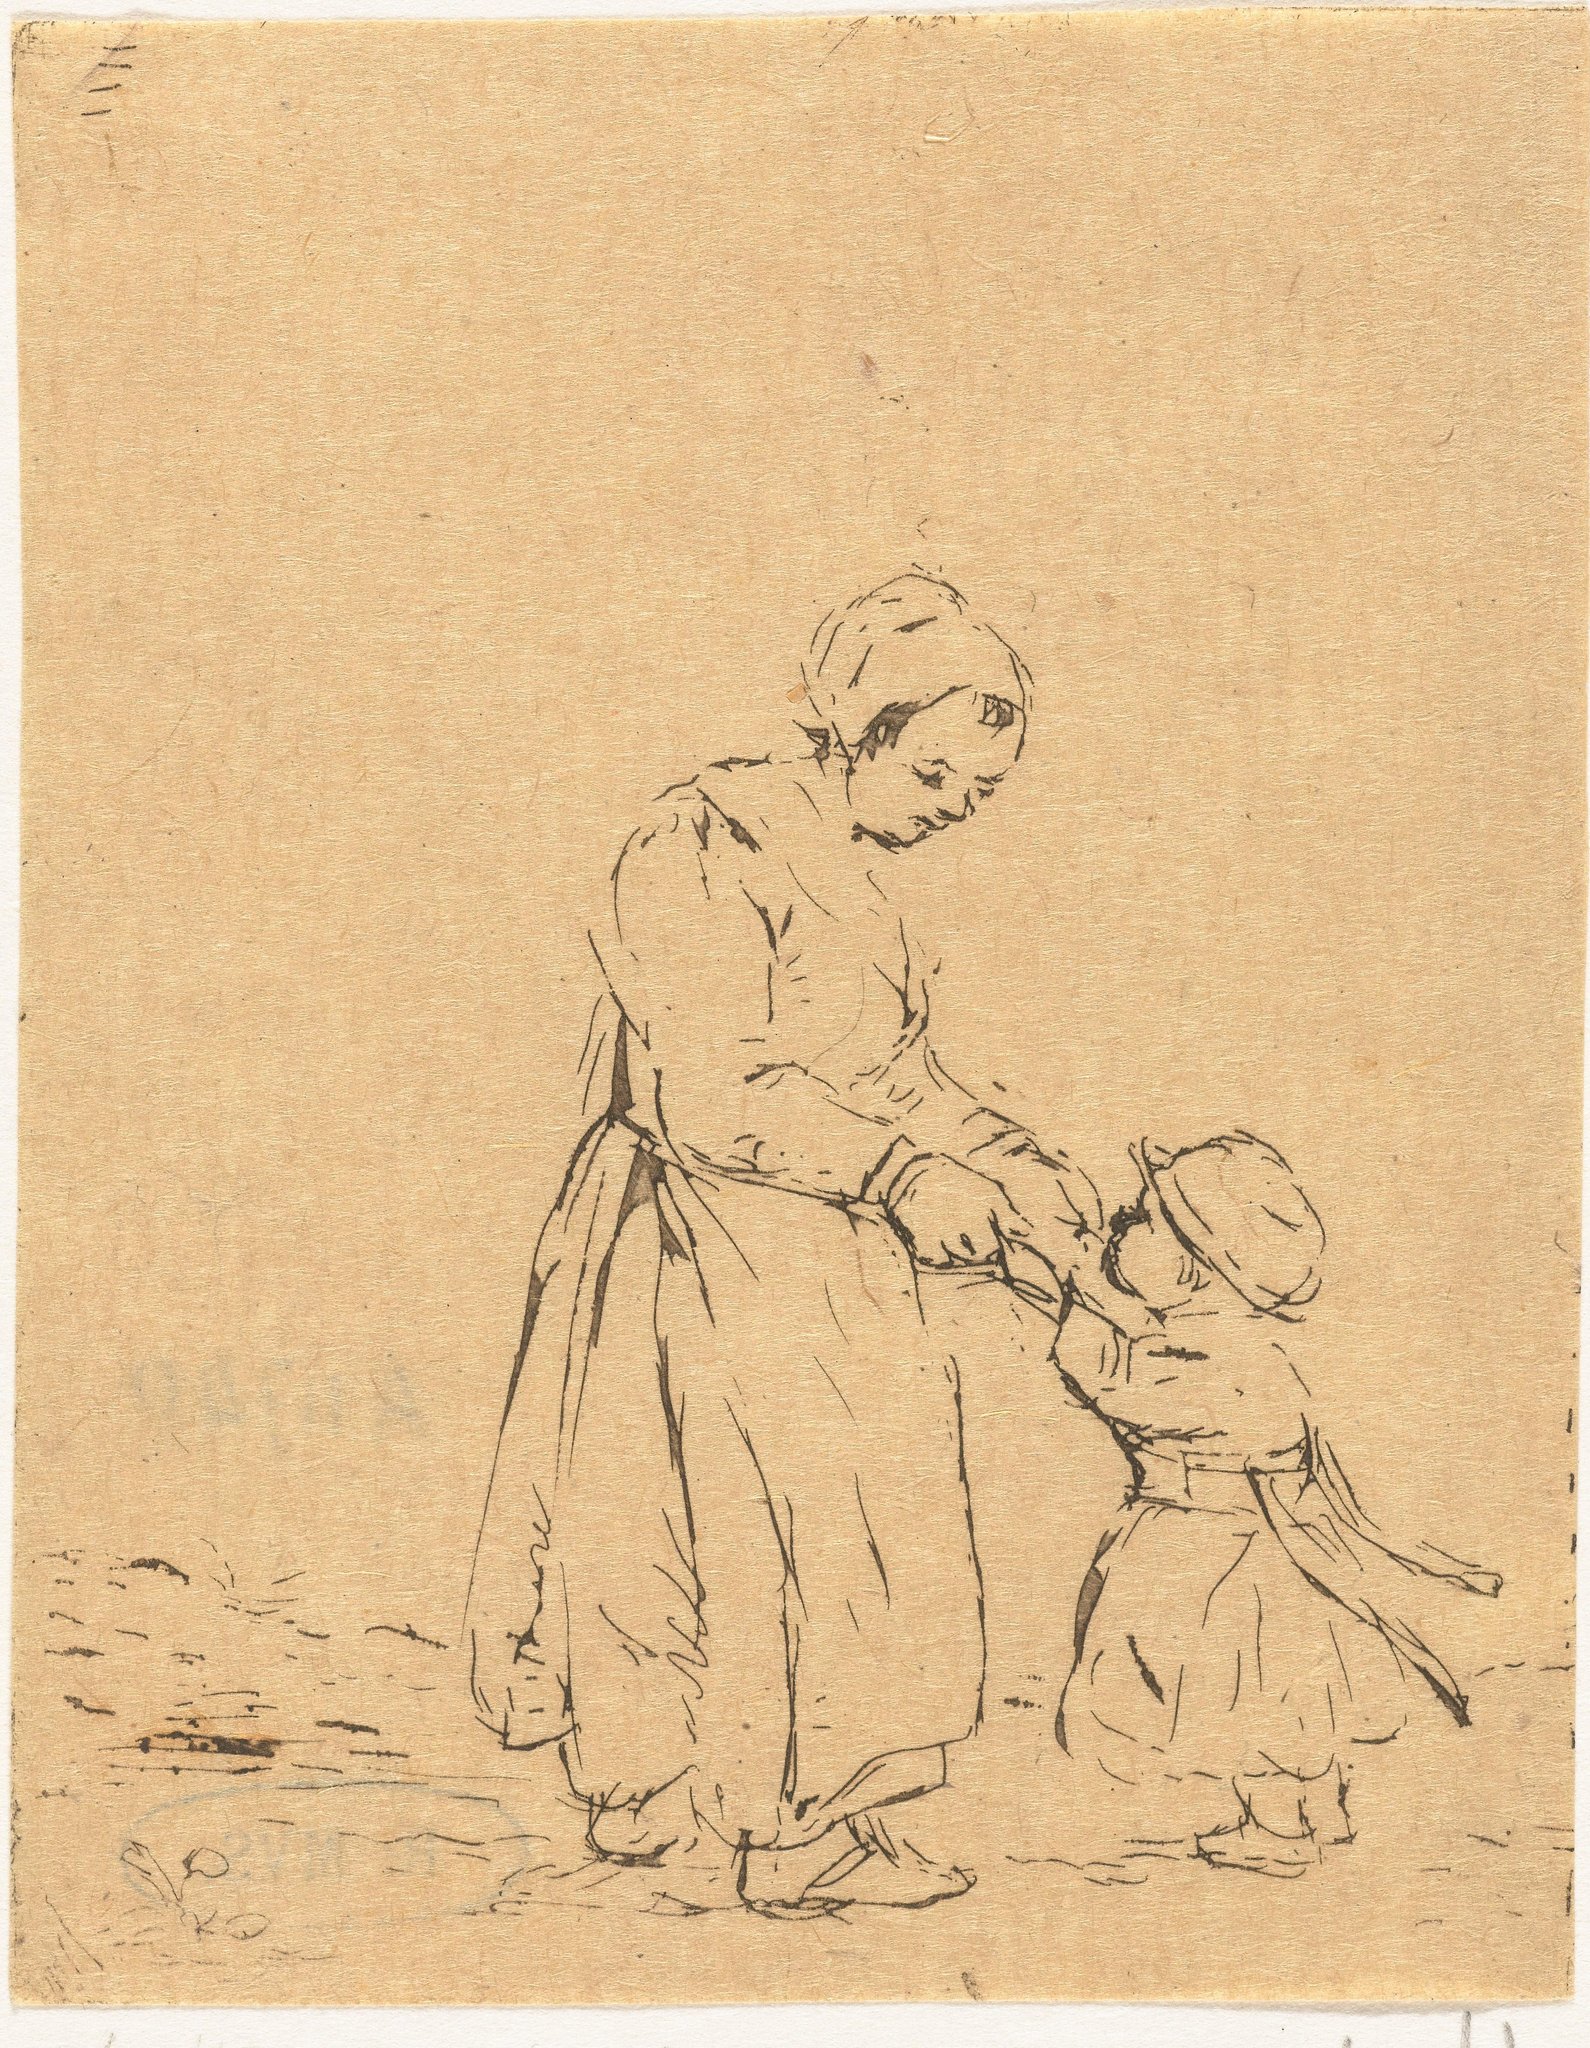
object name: print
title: Eerste stapjes van een kind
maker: christina chalon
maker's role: draughtsman, print maker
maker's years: 1748-1808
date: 1758-1808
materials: paper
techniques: etching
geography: leiden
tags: mother and child(ren), woman and child(ren) (family group) (with number of children), learning to walk, the first steps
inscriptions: collector's mark: Lugt 2228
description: Een moeder leert haar kind zijn eerste stapjes zetten. Ze houdt het vast met beide handjes.